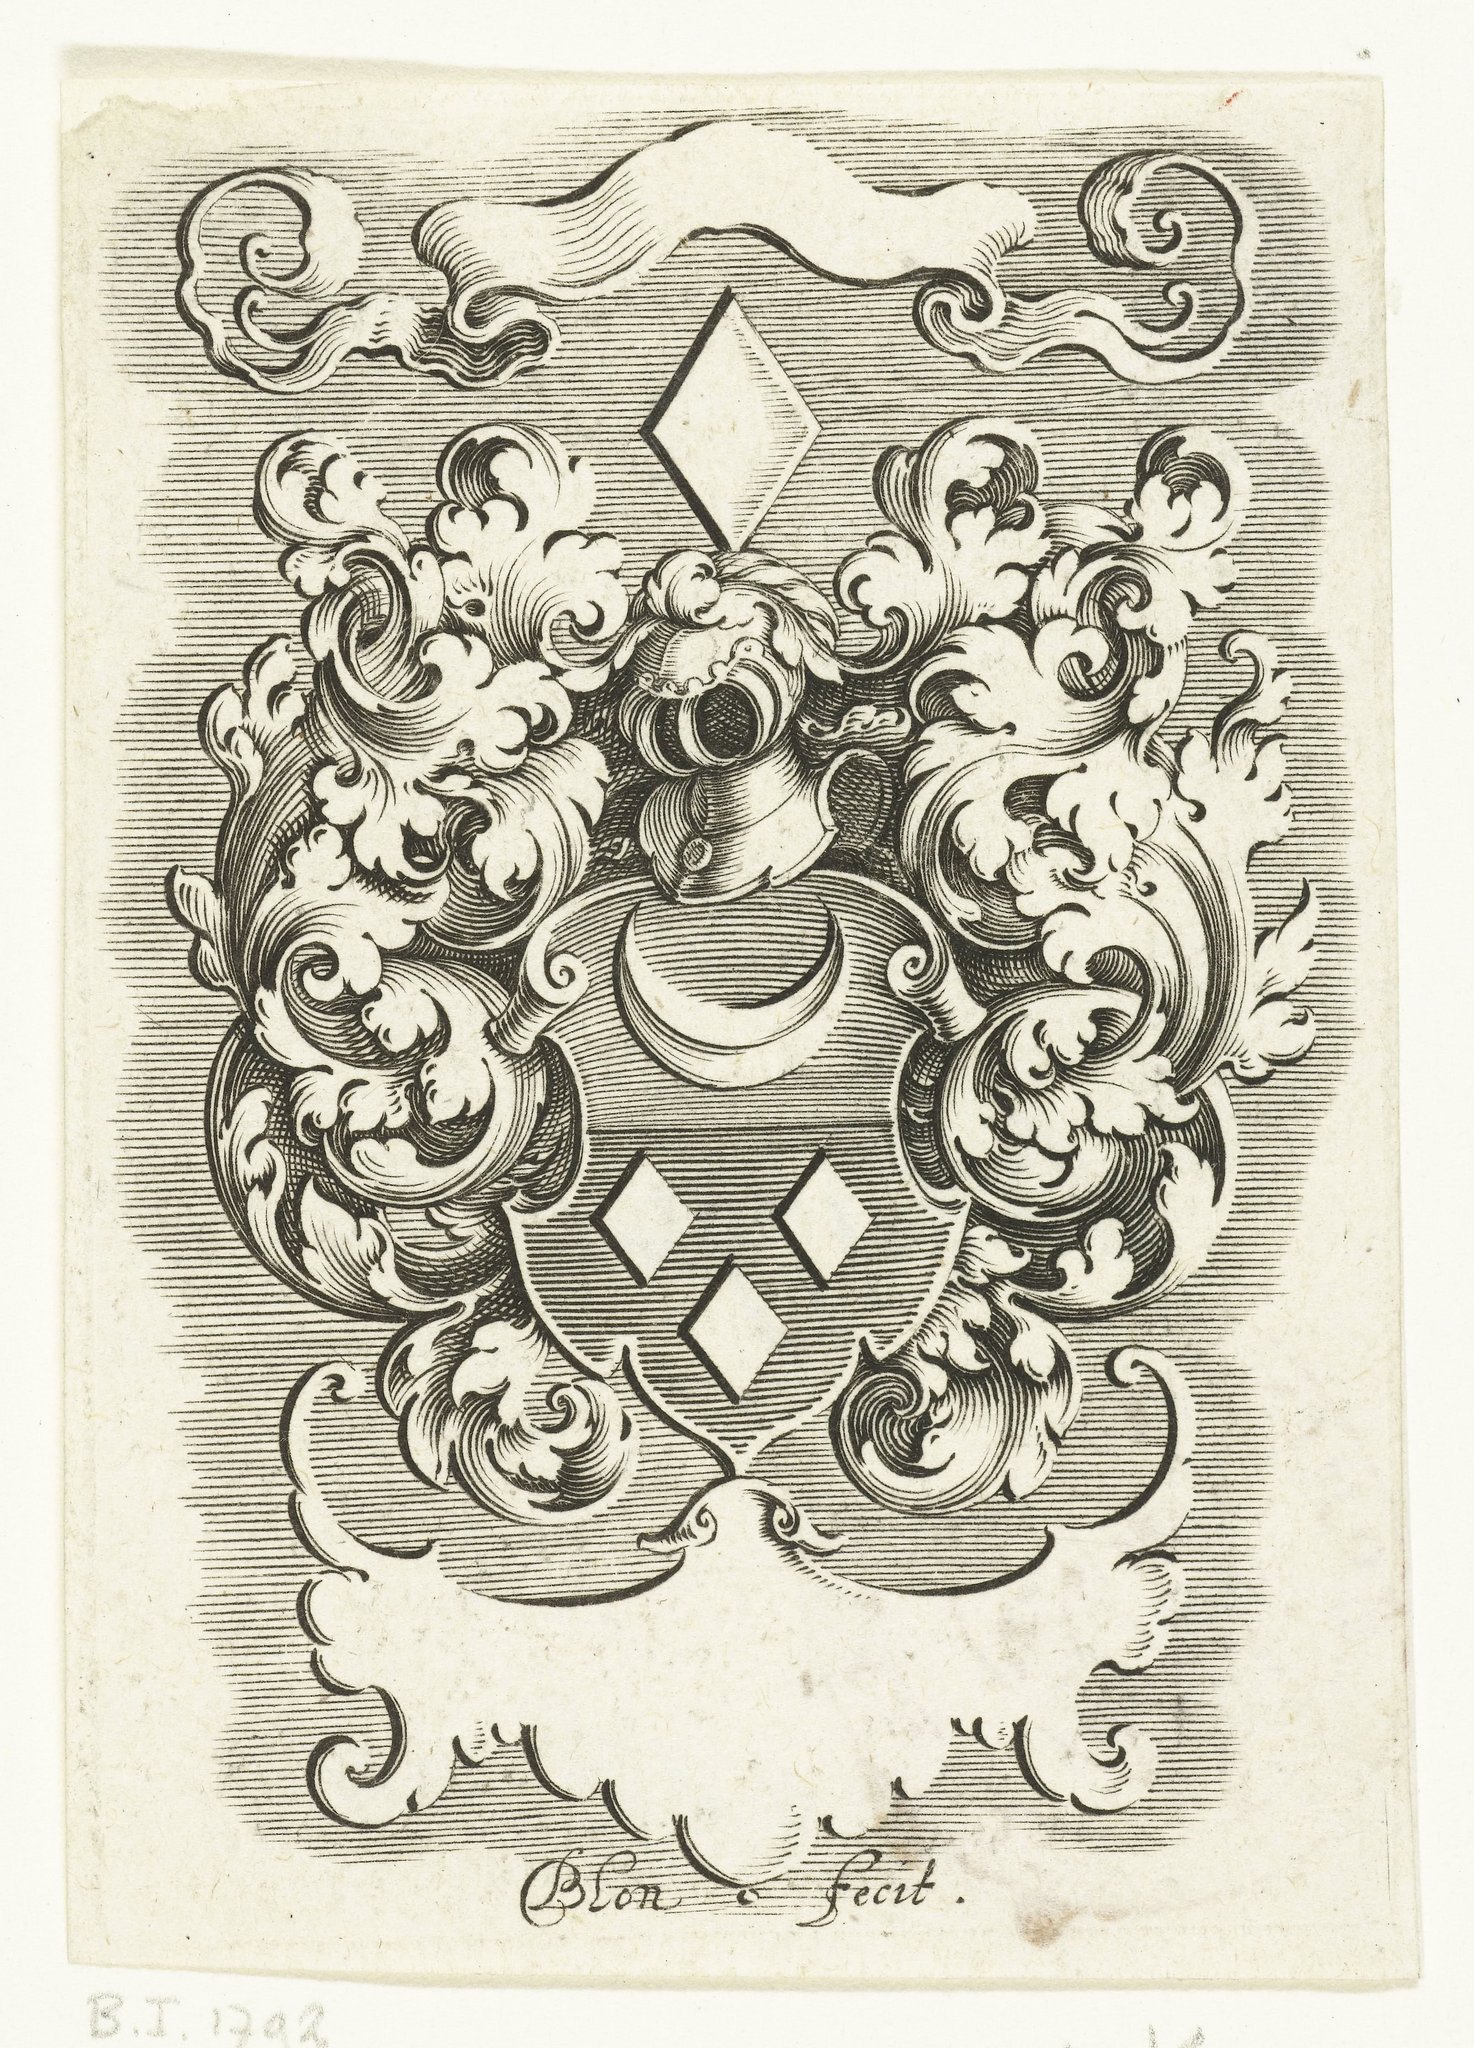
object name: ornament print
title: Wapenschild van de vrouw van Jean Rulant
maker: michiel le blon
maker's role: print maker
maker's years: 1587-1656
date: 1611-1625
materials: paper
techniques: engraving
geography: amsterdam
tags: armorial bearing, heraldry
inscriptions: collector's mark: Lugt 240